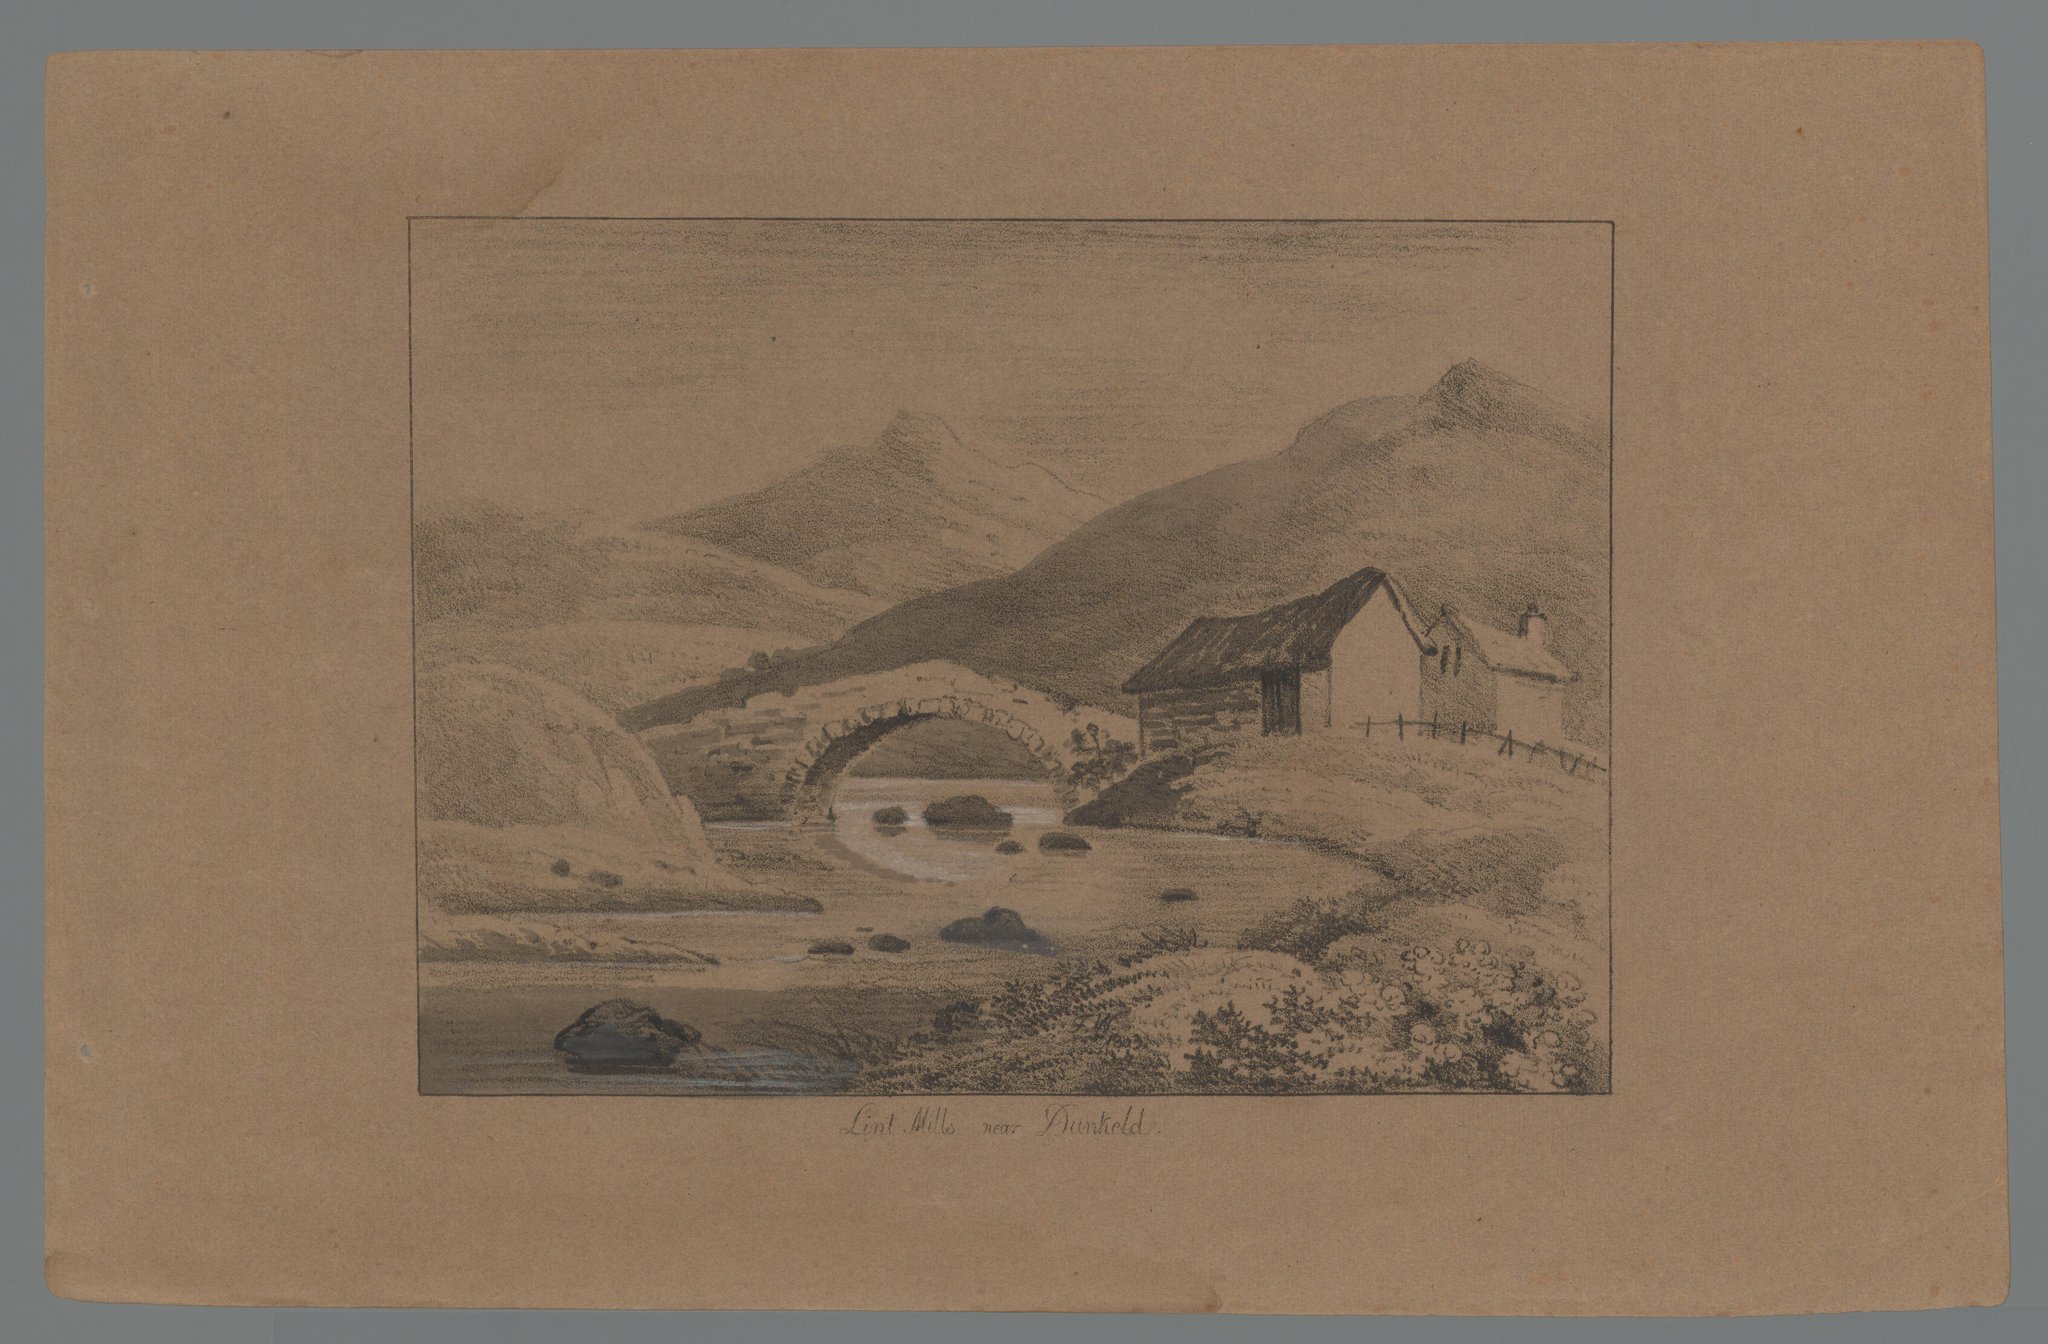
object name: print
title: Landschap met brug nabij Dunkeld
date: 1803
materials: chalk, ink, paper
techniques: brush, lithograph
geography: london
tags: low hill country, bridge, landscapes in the temperate zone (+ landscape with figures, staffage)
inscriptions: collector's mark: Lugt 2233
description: Deze prent behoort tot de serie 'Twelve views in Scotland, delineated by a lady in the polyautographic art of drawing on stone'. Deze serie met twaalf lithografieën is een van de vroegste reeksen lithografieën in Groot-Brittannië.